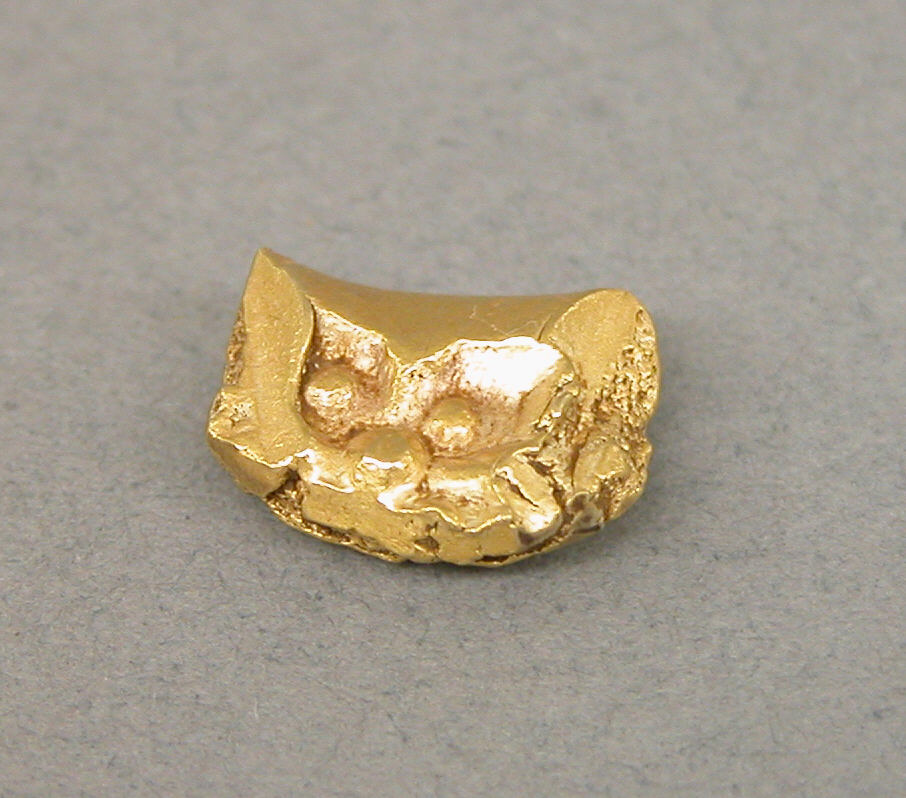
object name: coin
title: Large Piloncito Coin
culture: indonesian, javanese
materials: gold